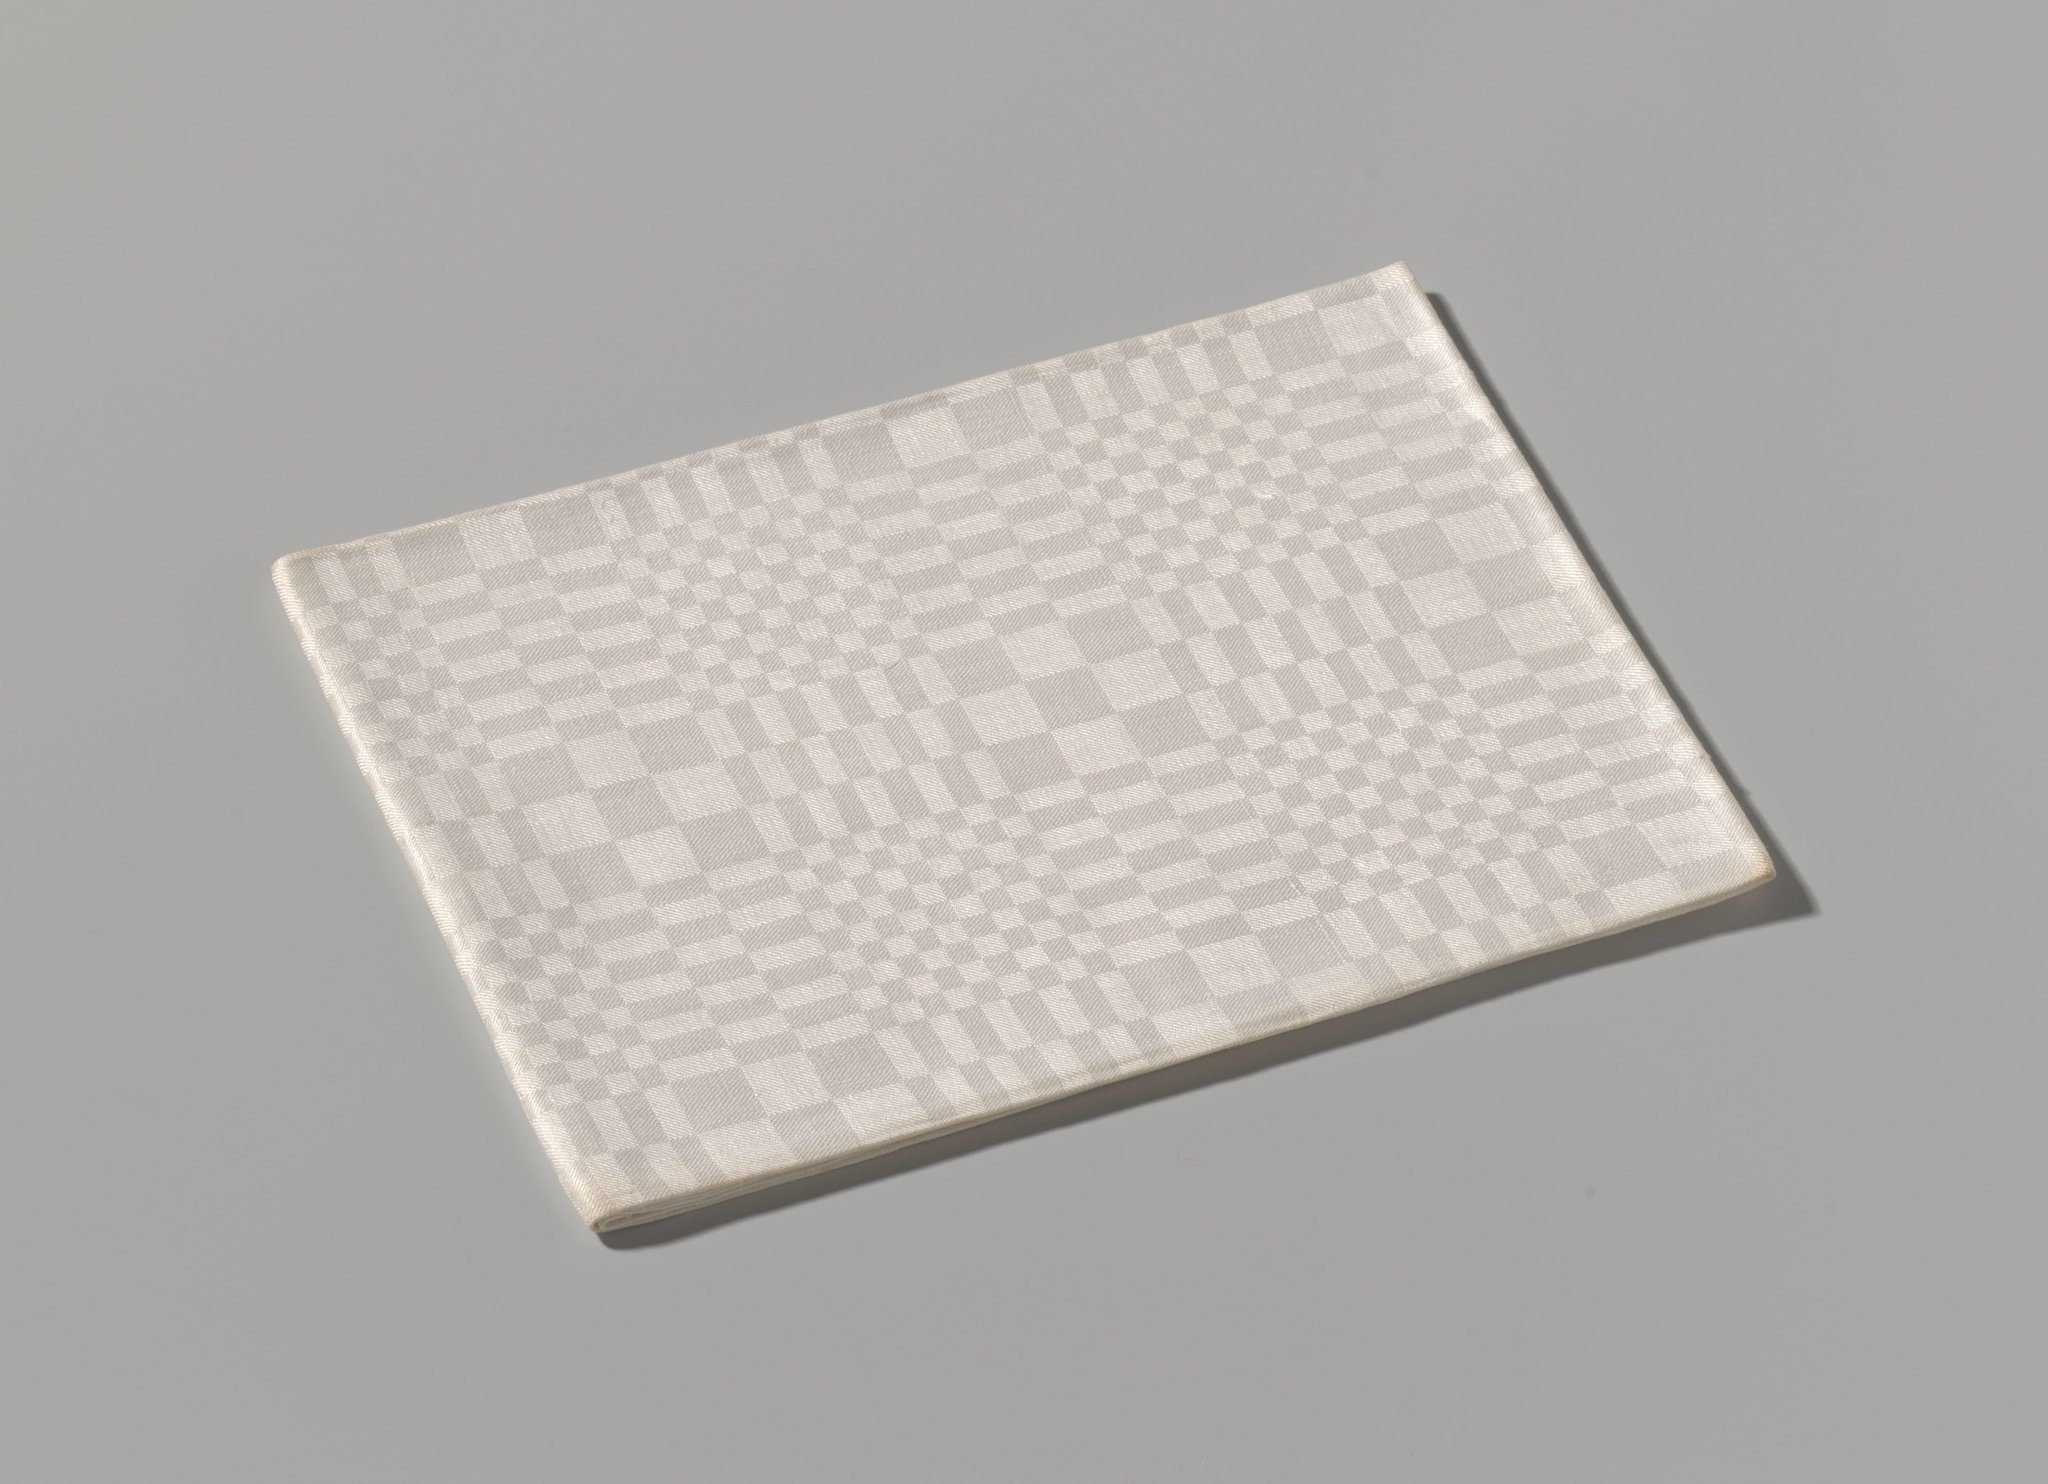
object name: napkin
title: Servet van pellendamast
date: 1739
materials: linen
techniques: weave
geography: northern netherlands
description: Wit linnen servet met pellenpatroon, genaamd "Engelse garderobe". Merk kroon WG 36 1739.